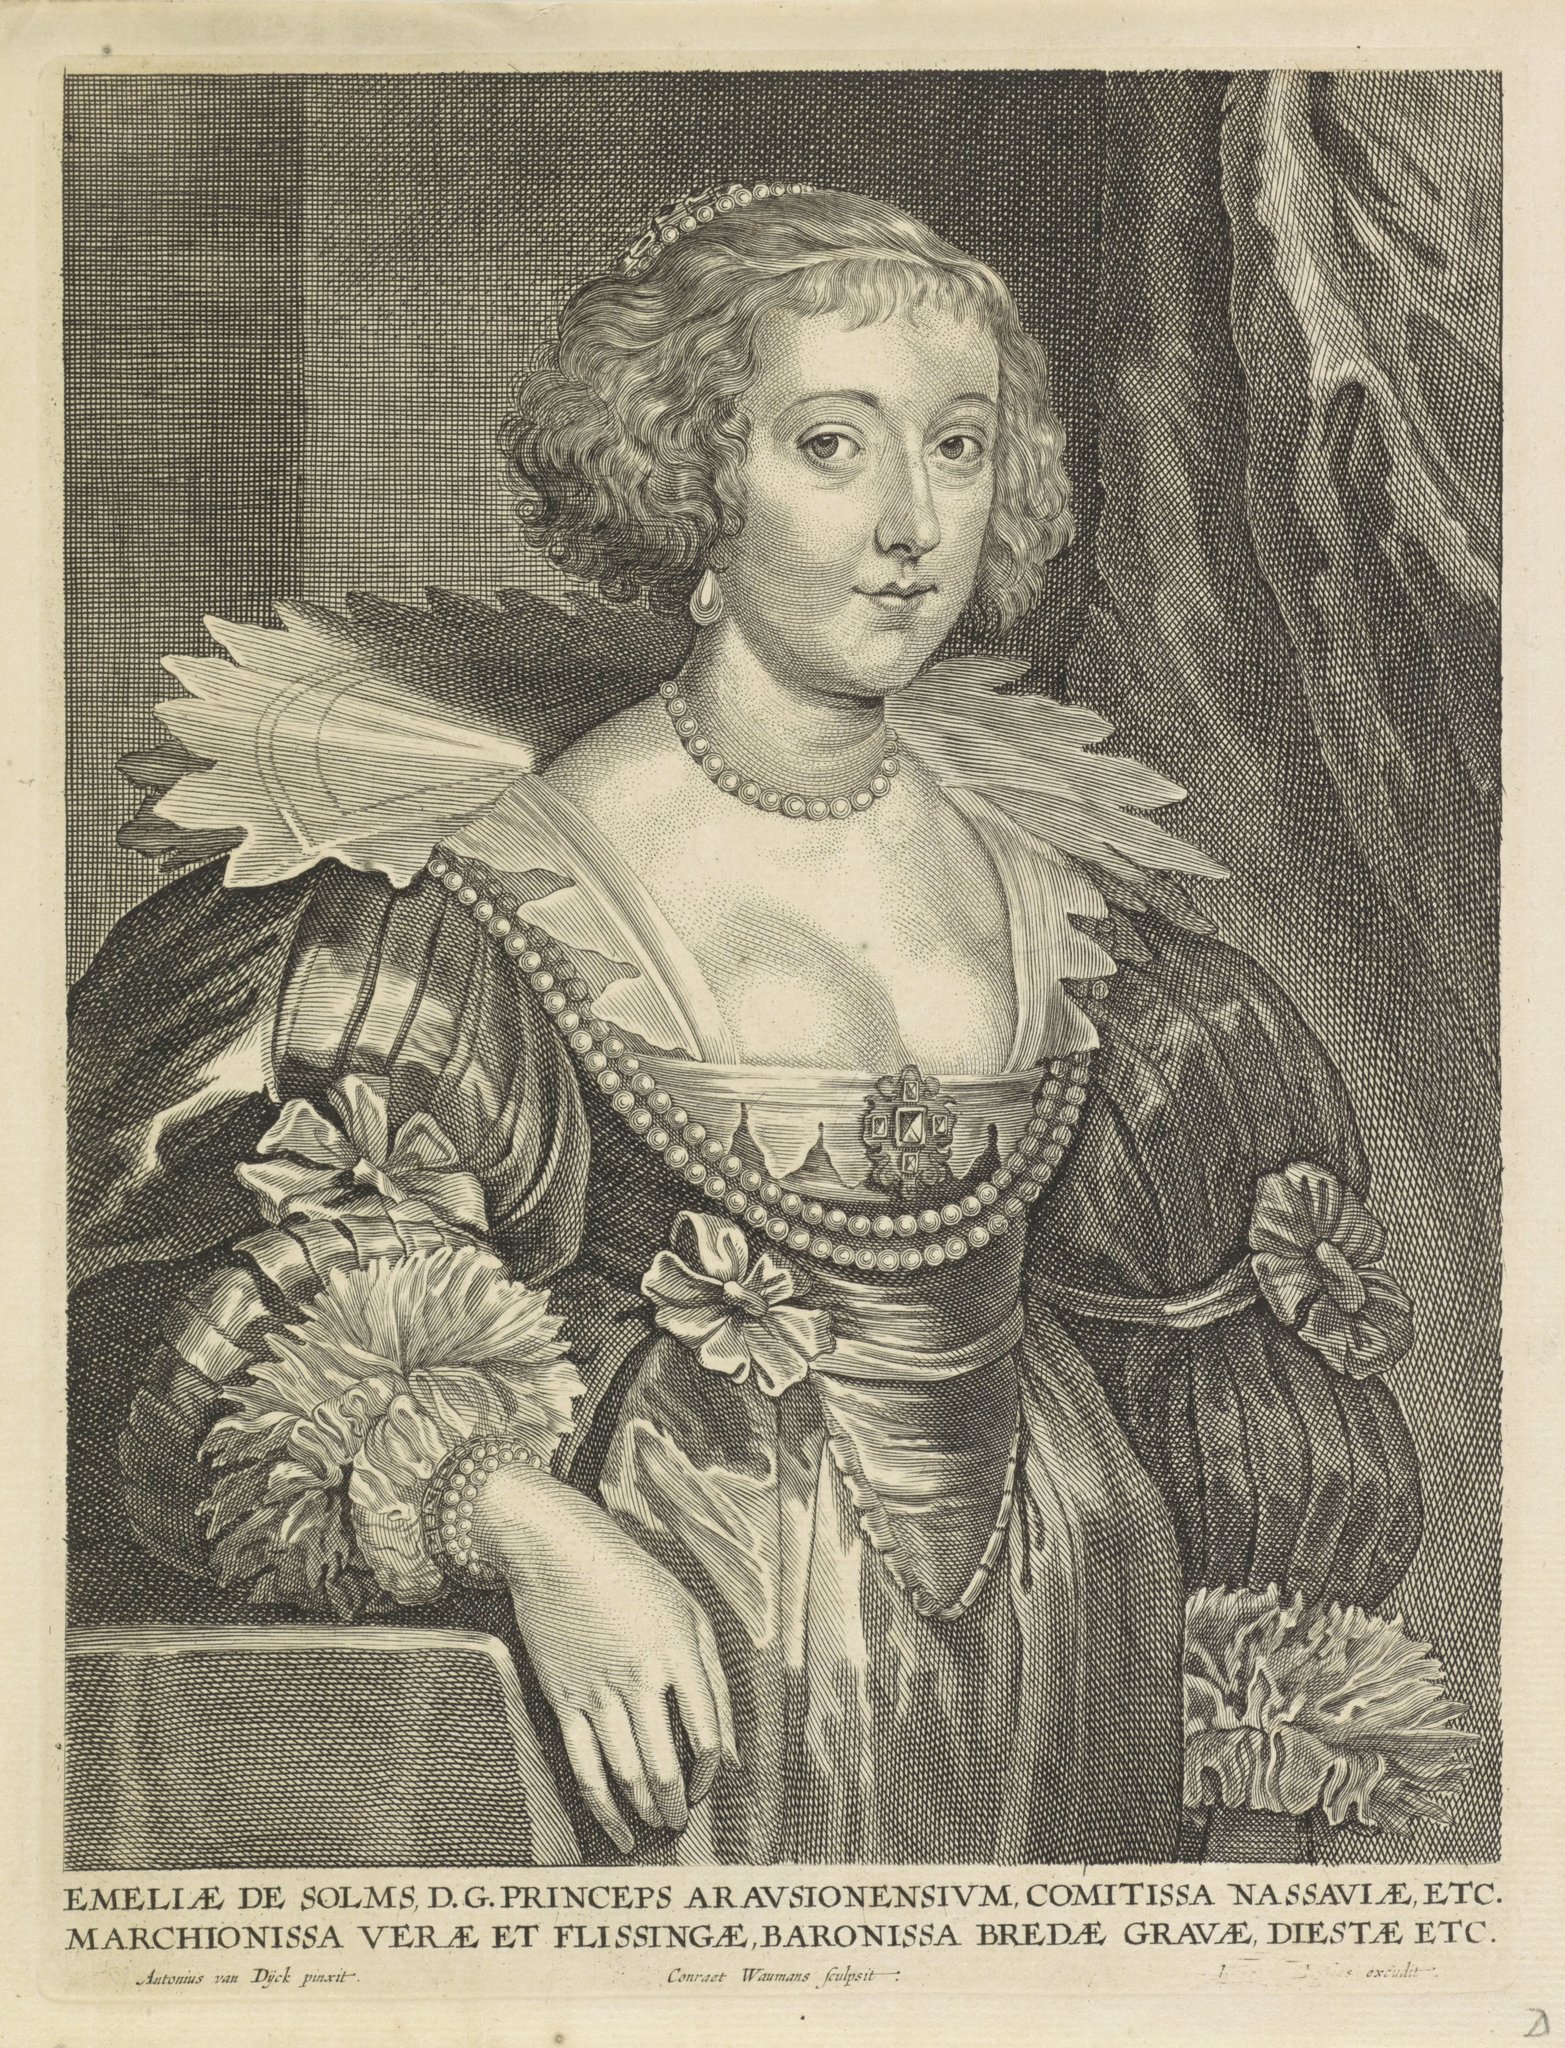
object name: print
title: Portret van Amalia van Solms, prinses van Oranje-Nassau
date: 1633-1673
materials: paper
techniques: engraving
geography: antwerp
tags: amalia of solms-braunfels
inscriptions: collector's mark: Lugt 2228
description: Portret van Amalia van Solms, prinses van Oranje-Nassau. In de marge een tweeregelig onderschrift in het Latijn.